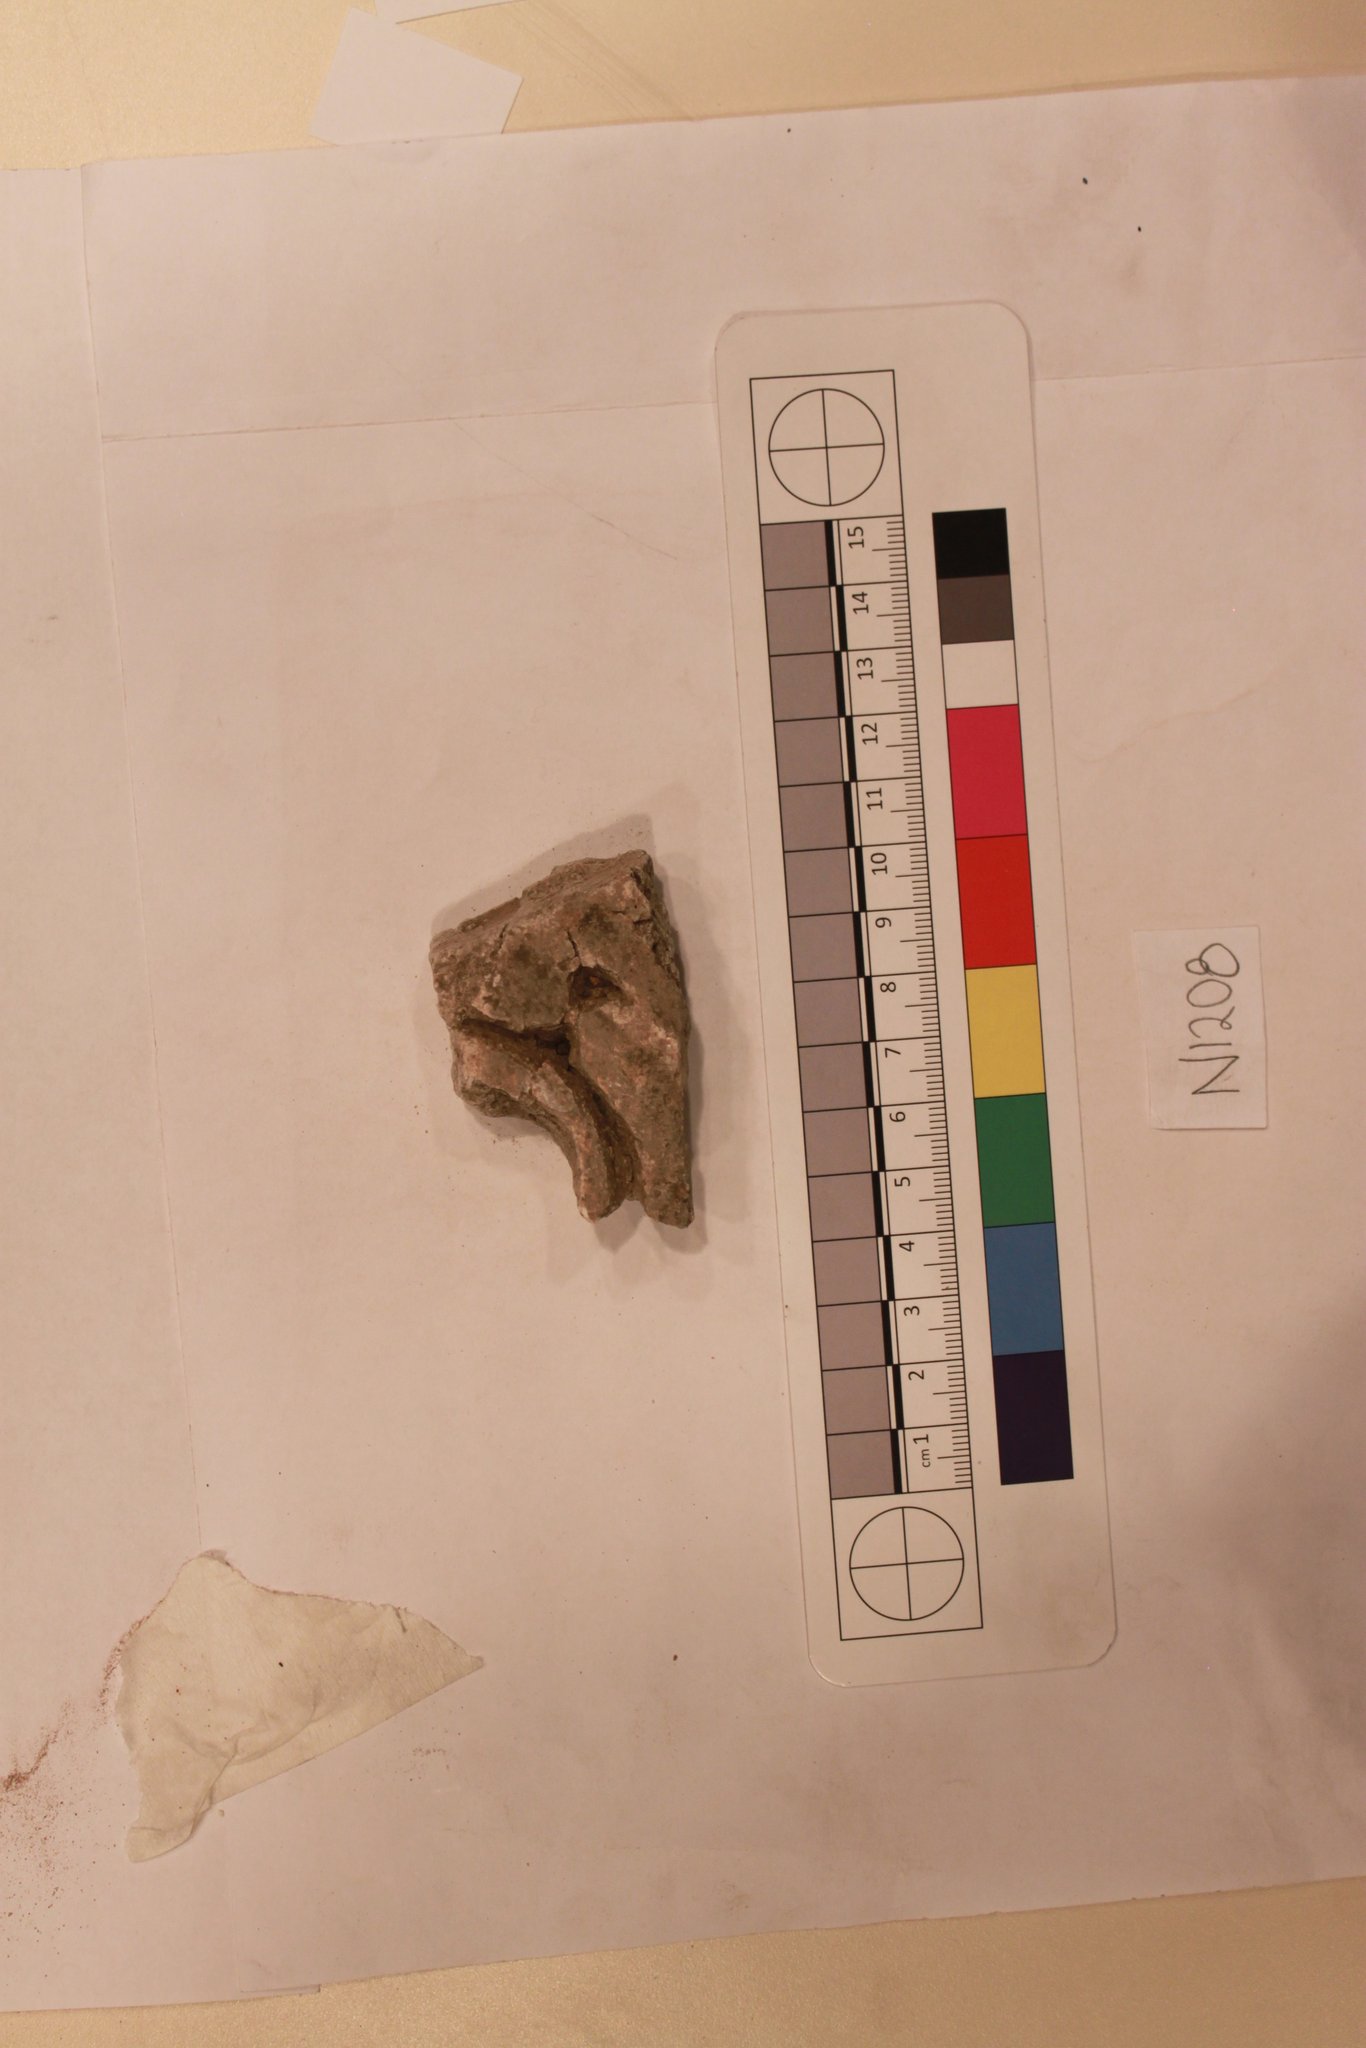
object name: fragment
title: Stucco Fragment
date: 701-1200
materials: plaster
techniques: carving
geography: iran